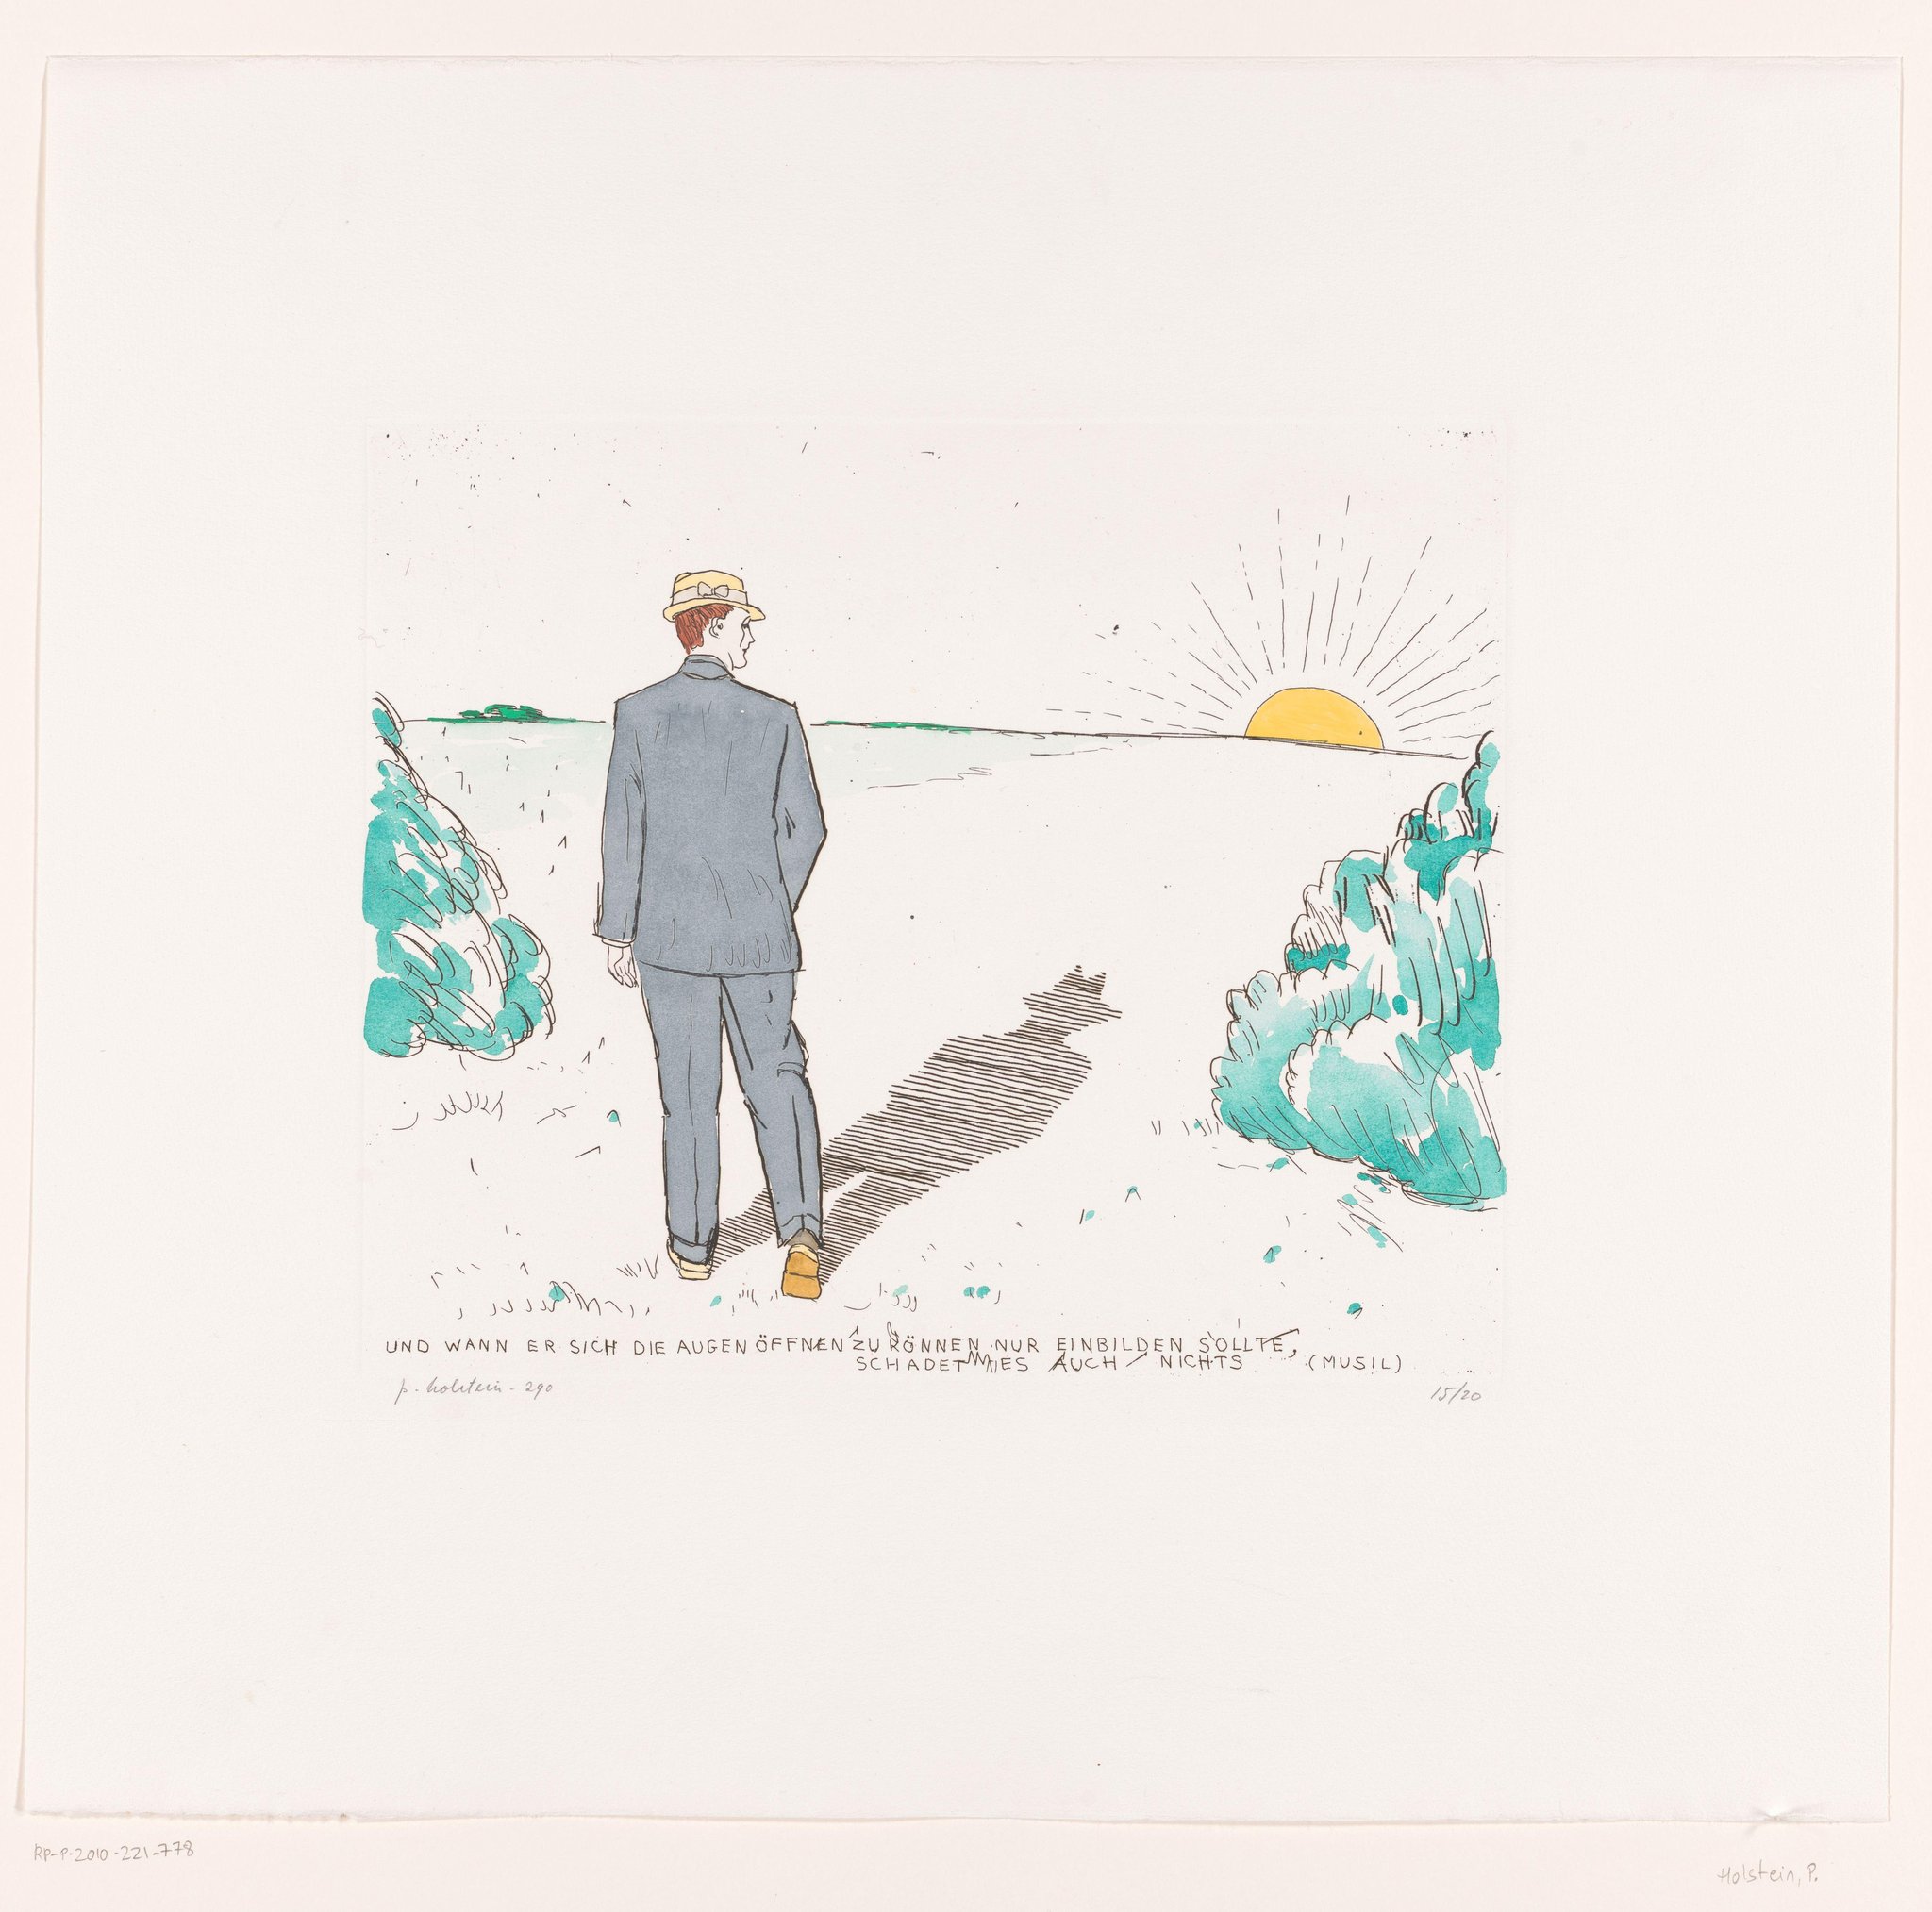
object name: print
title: Und wann er sich die Augen öffnen [Musil]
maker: pieter holstein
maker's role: draughtsman, painter, print maker, sculptor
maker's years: 1934-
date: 1974-1984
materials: paper, watercolor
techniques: brush, etching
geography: amsterdam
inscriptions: inscription: ‘290’, edition: ‘15/20’, title: ‘UND WANN ER SICH DIE AUGEN ÖFFNEN ZU KÖNNEN NUR EINBILDEN SOLLTE / SCHADET ES AUCH NICHTS’, signature: ‘p. holstein’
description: Man met hoed in landschap, aan de horizon een opkomende of opgaande zon, zijn schaduw in de richting van het licht.